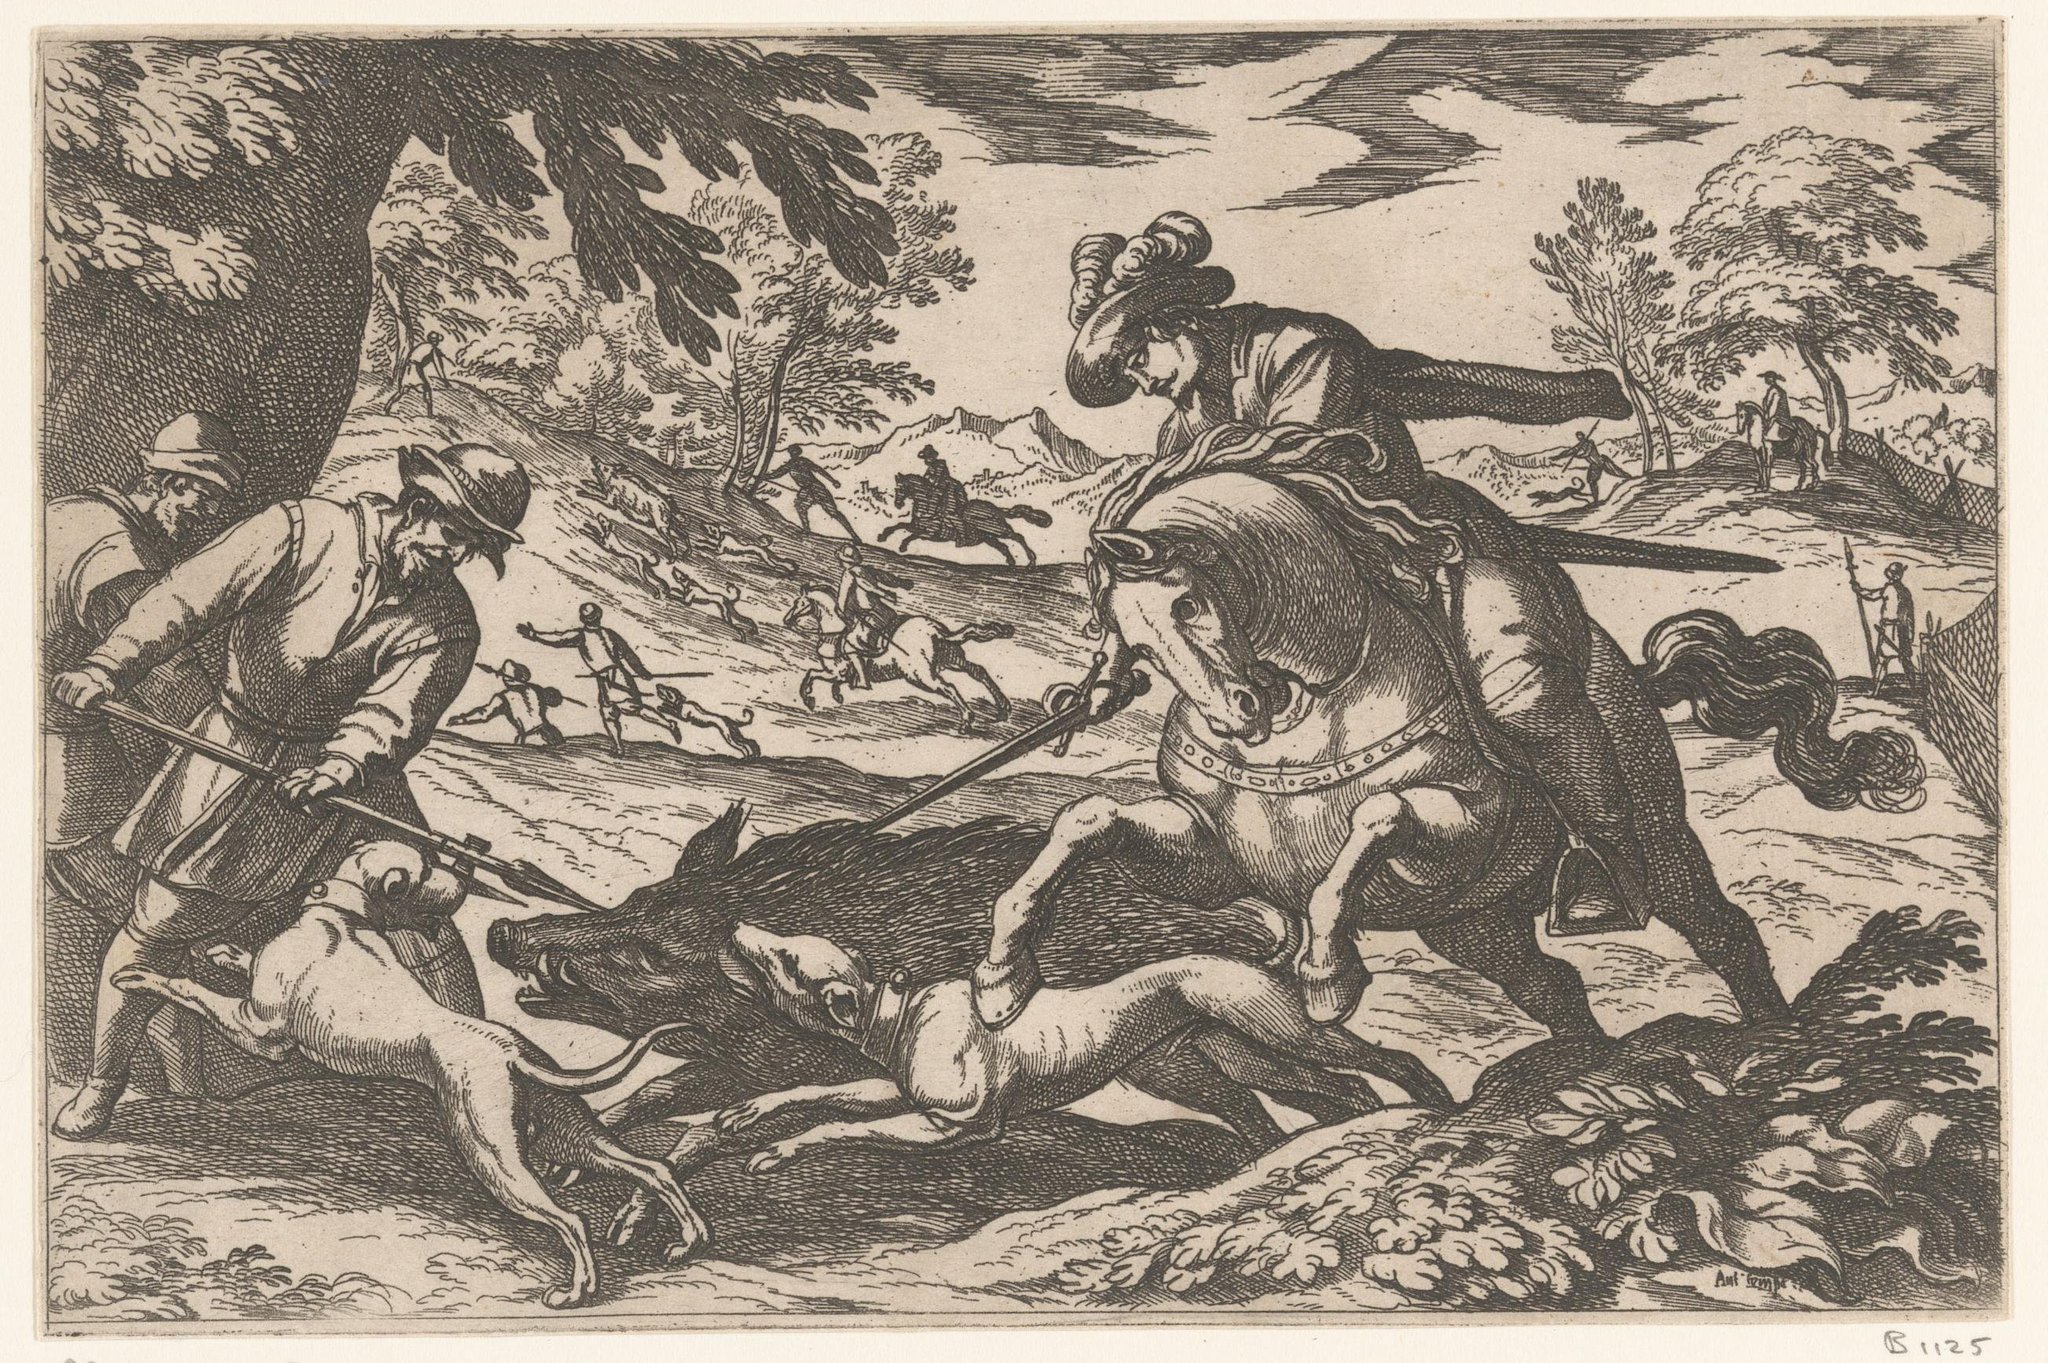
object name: print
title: Jachtscènes (deel 4)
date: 1595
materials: paper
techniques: etching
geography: italy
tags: boar-hunting, hunter, hunters hunting (n.b.: in 1988-1990 this notation denoted the concept of 43c11421 'hunters resting during the hunt')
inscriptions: collector's mark: Lugt 240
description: Deze prent maakt deel uit van een reeks van elf prenten met jachtscènes (+ opdracht).